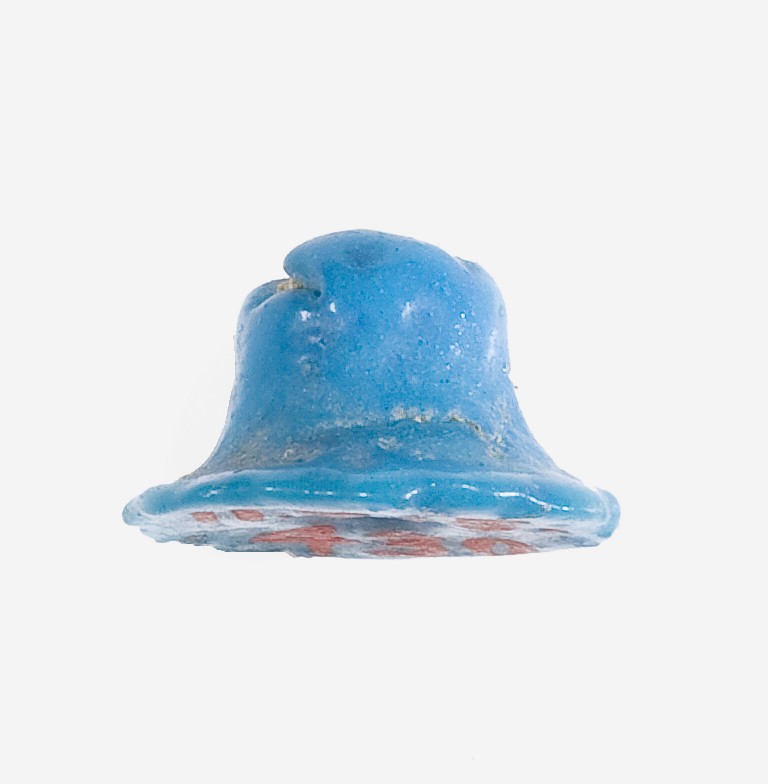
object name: pendant, umbel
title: Umbel Pendant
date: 1390-1352 BCE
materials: faience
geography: egypt